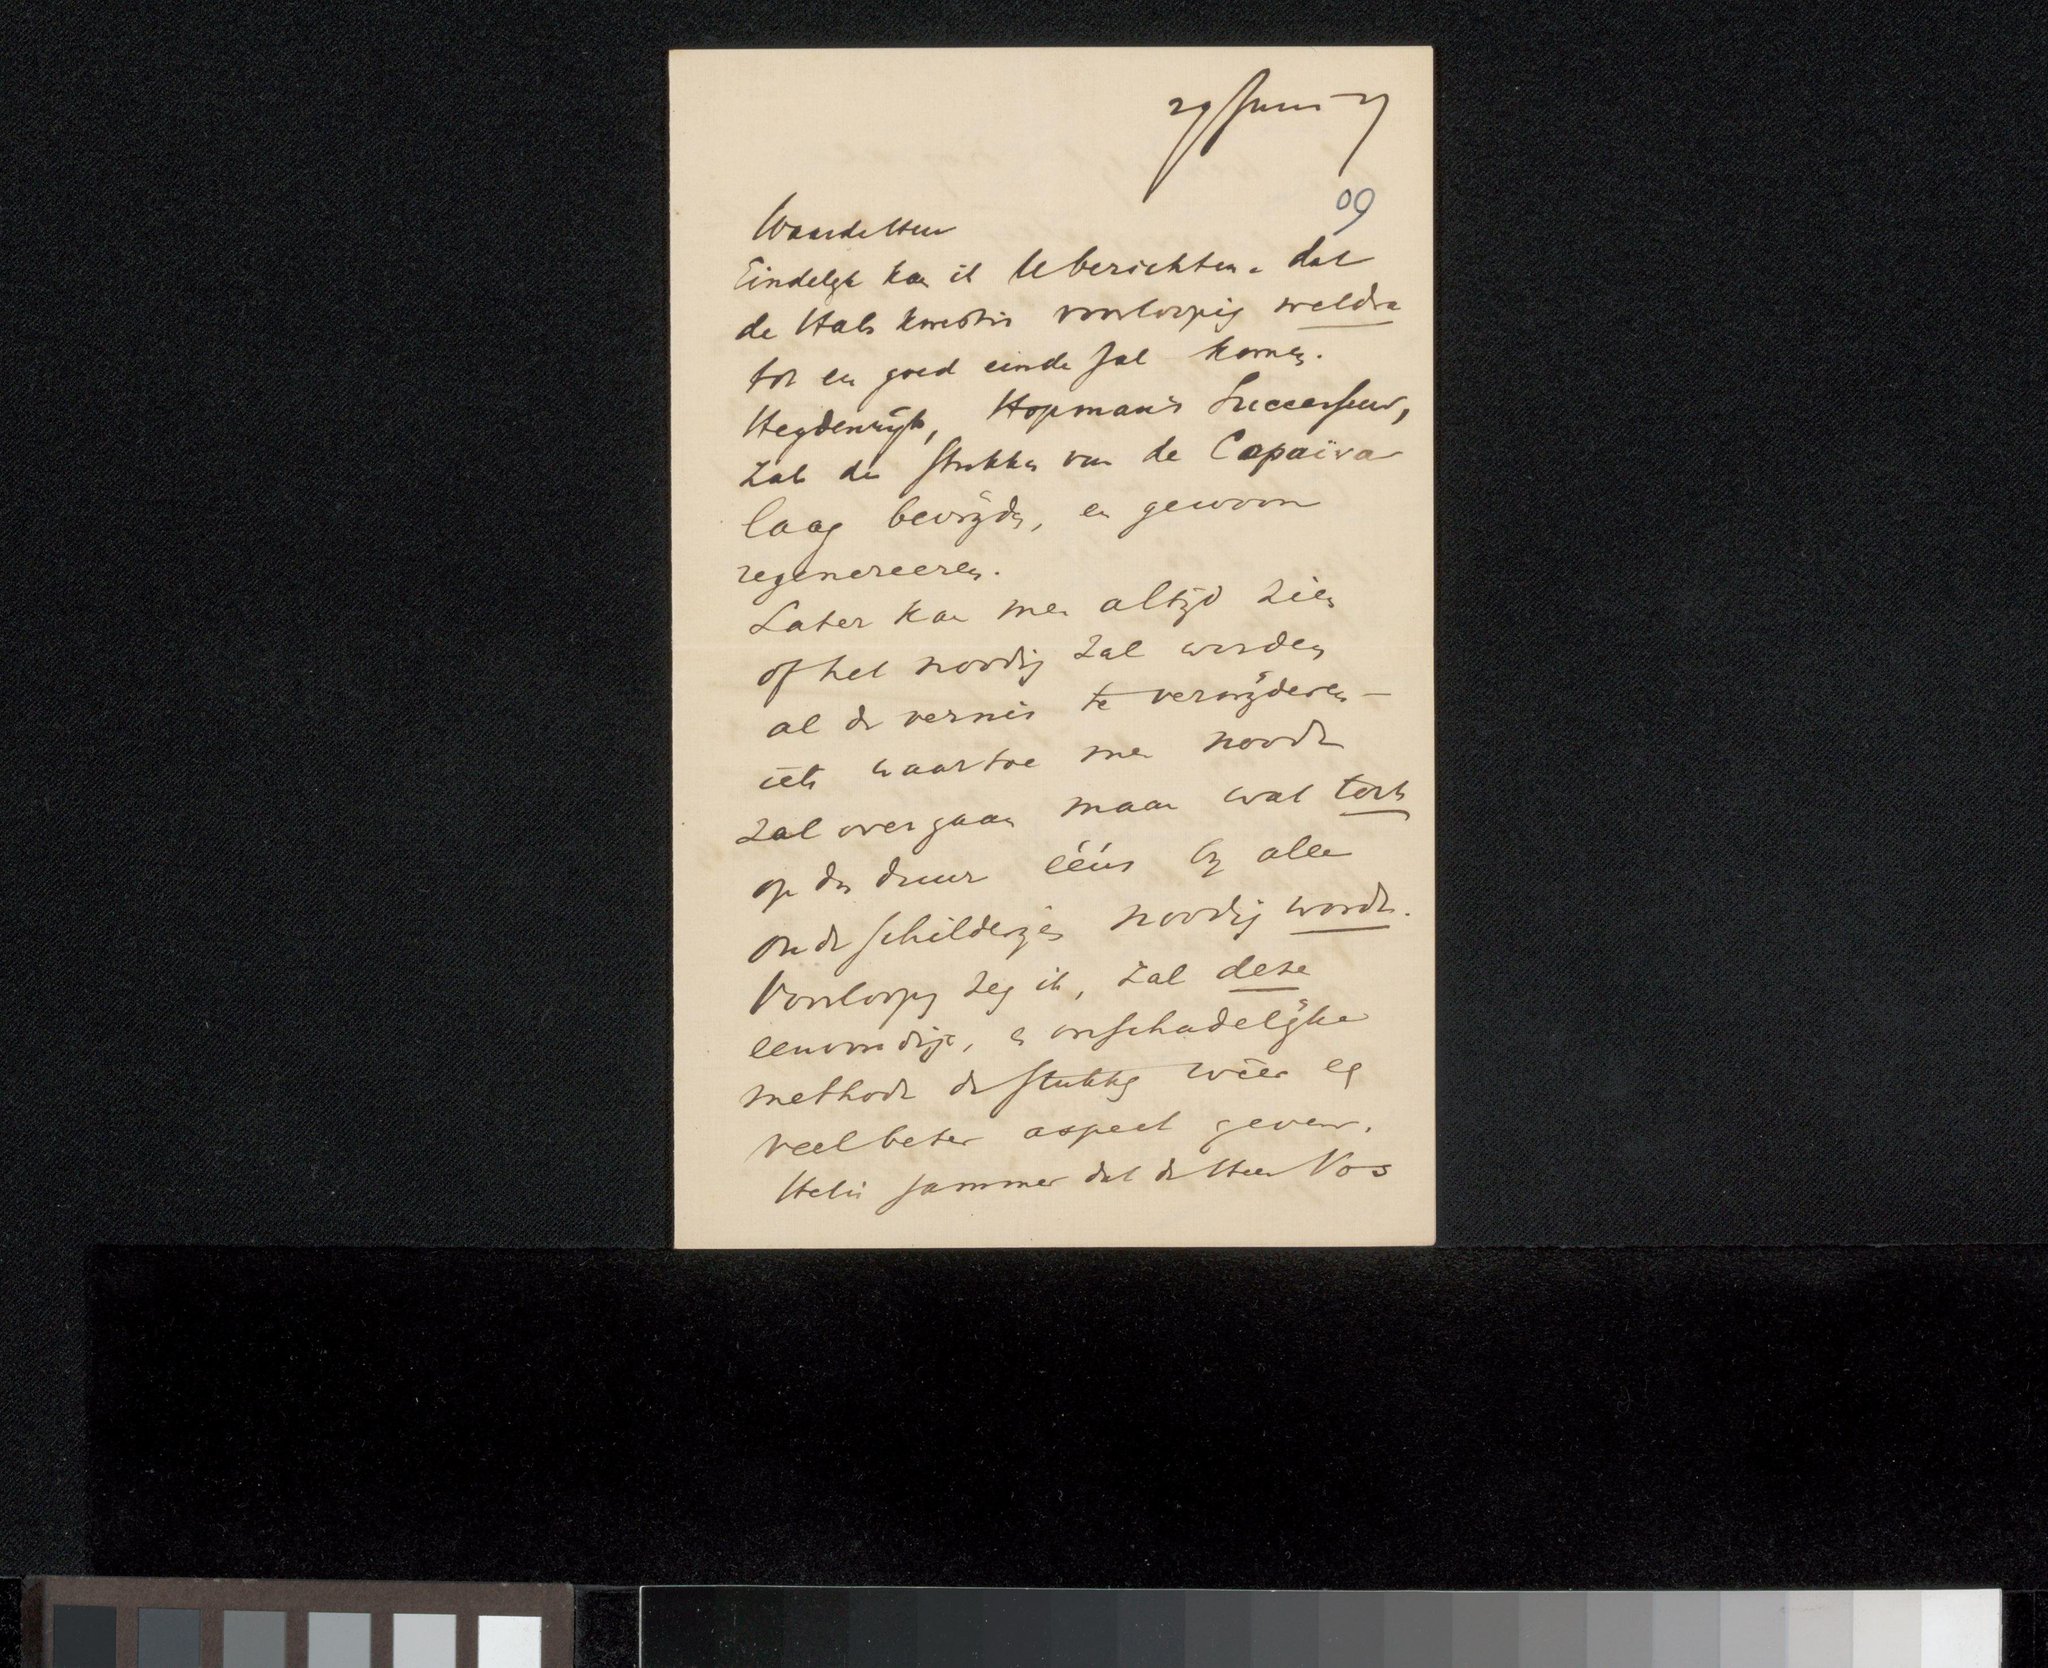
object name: letter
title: Brief aan Jan Veth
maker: abraham bredius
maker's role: kunsthistoricus, museumdirecteur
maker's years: 1855-1946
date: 1909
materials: ink, paper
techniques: pen, writing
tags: dordrecht, print maker, draughtsman, designer, jan veth, frans hals, leiden, rembrandt van rijn, haarlem, painter, conservator, art trade, art shop, money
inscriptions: collector's mark: ‘RPK’